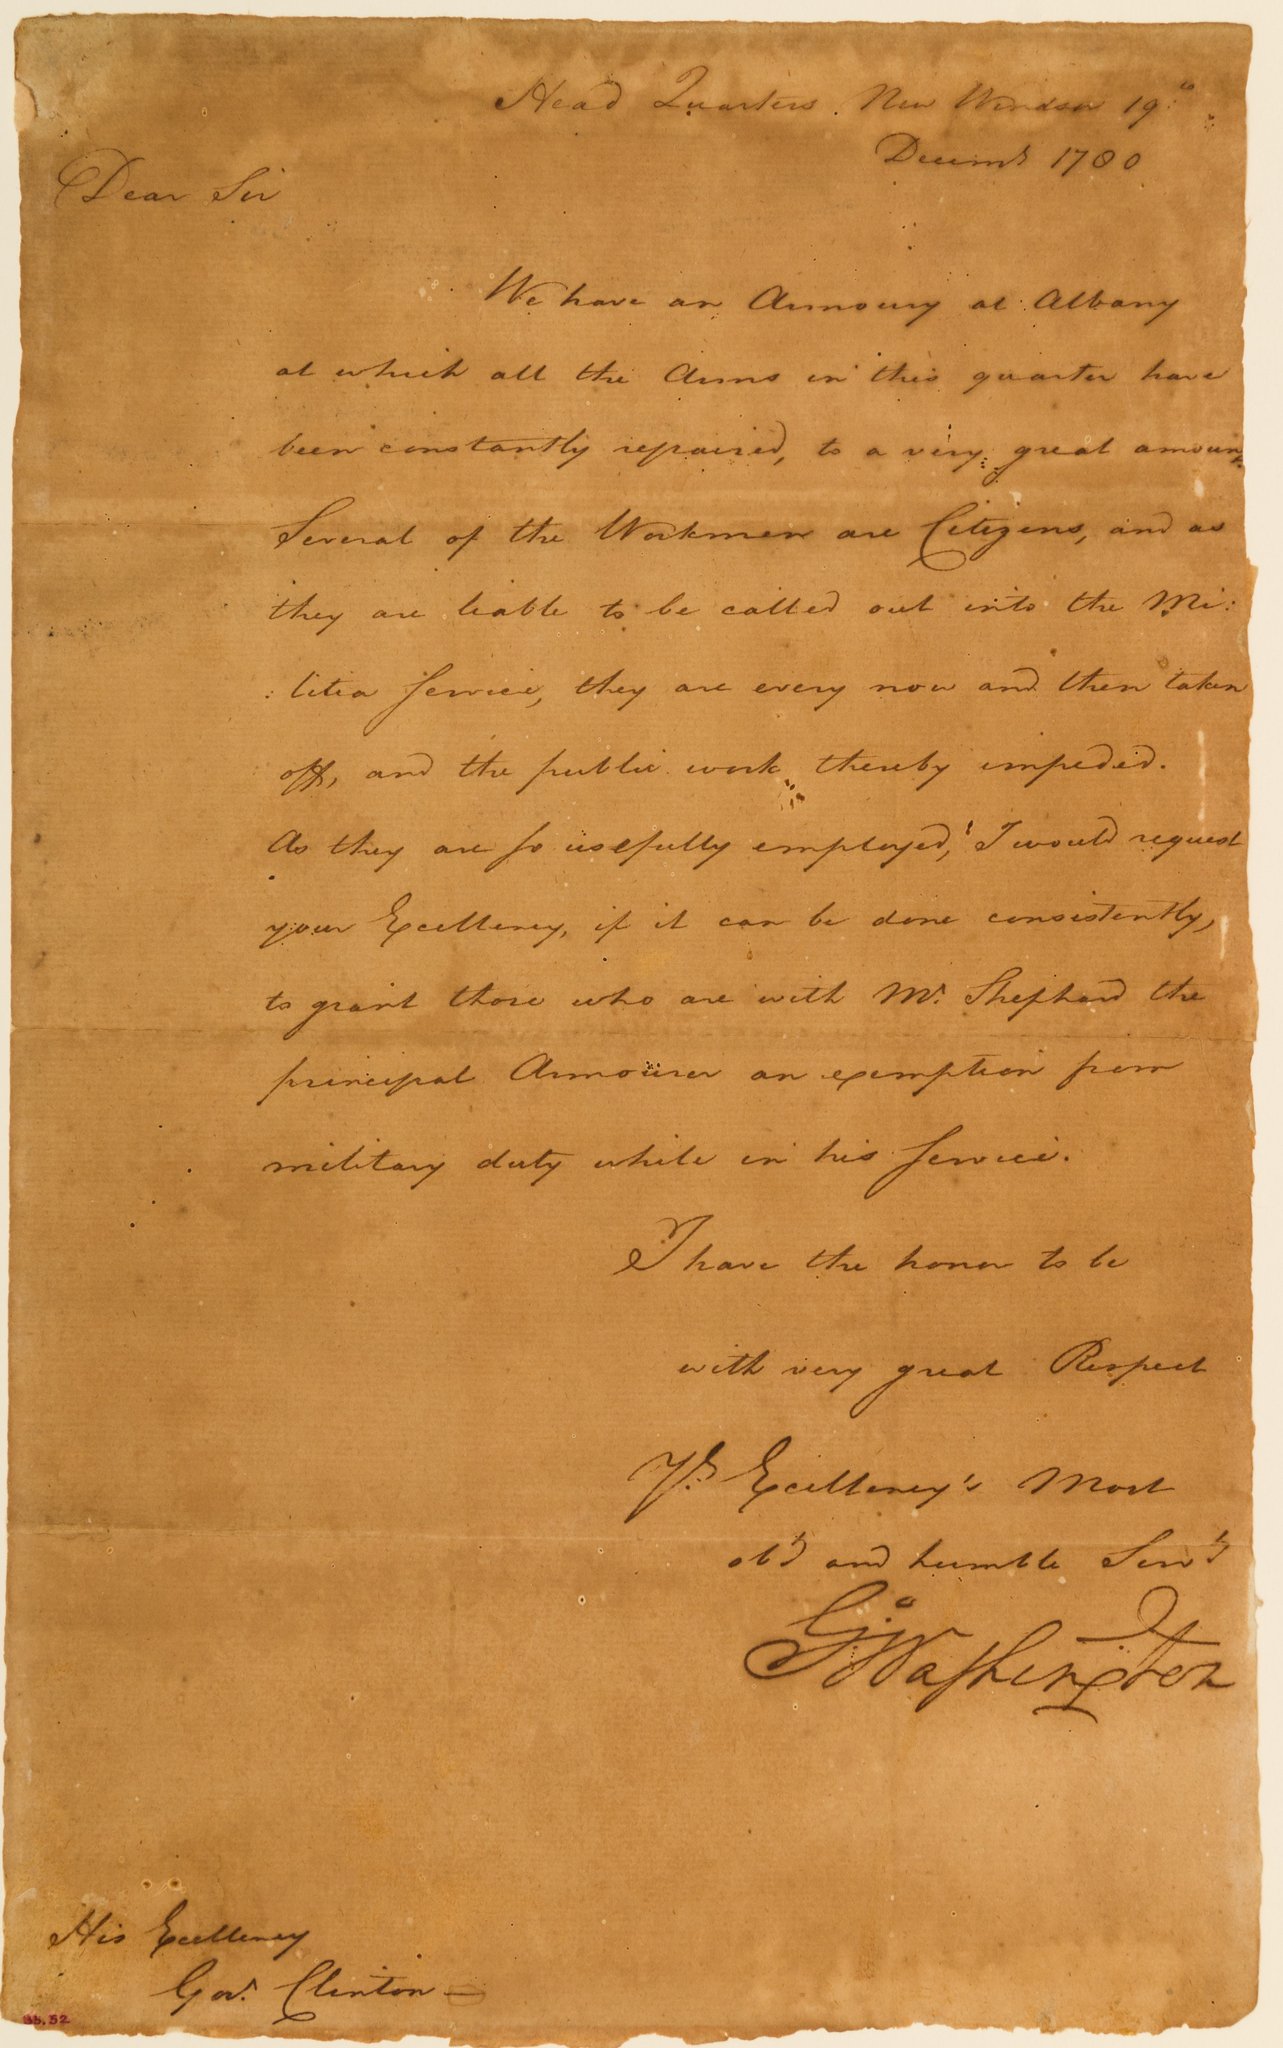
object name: letter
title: Letter from George Washington to New York Governor George Clinton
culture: american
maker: george washington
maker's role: author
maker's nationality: american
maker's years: 1732-1799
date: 1780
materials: ink, paper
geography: united states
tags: george washington